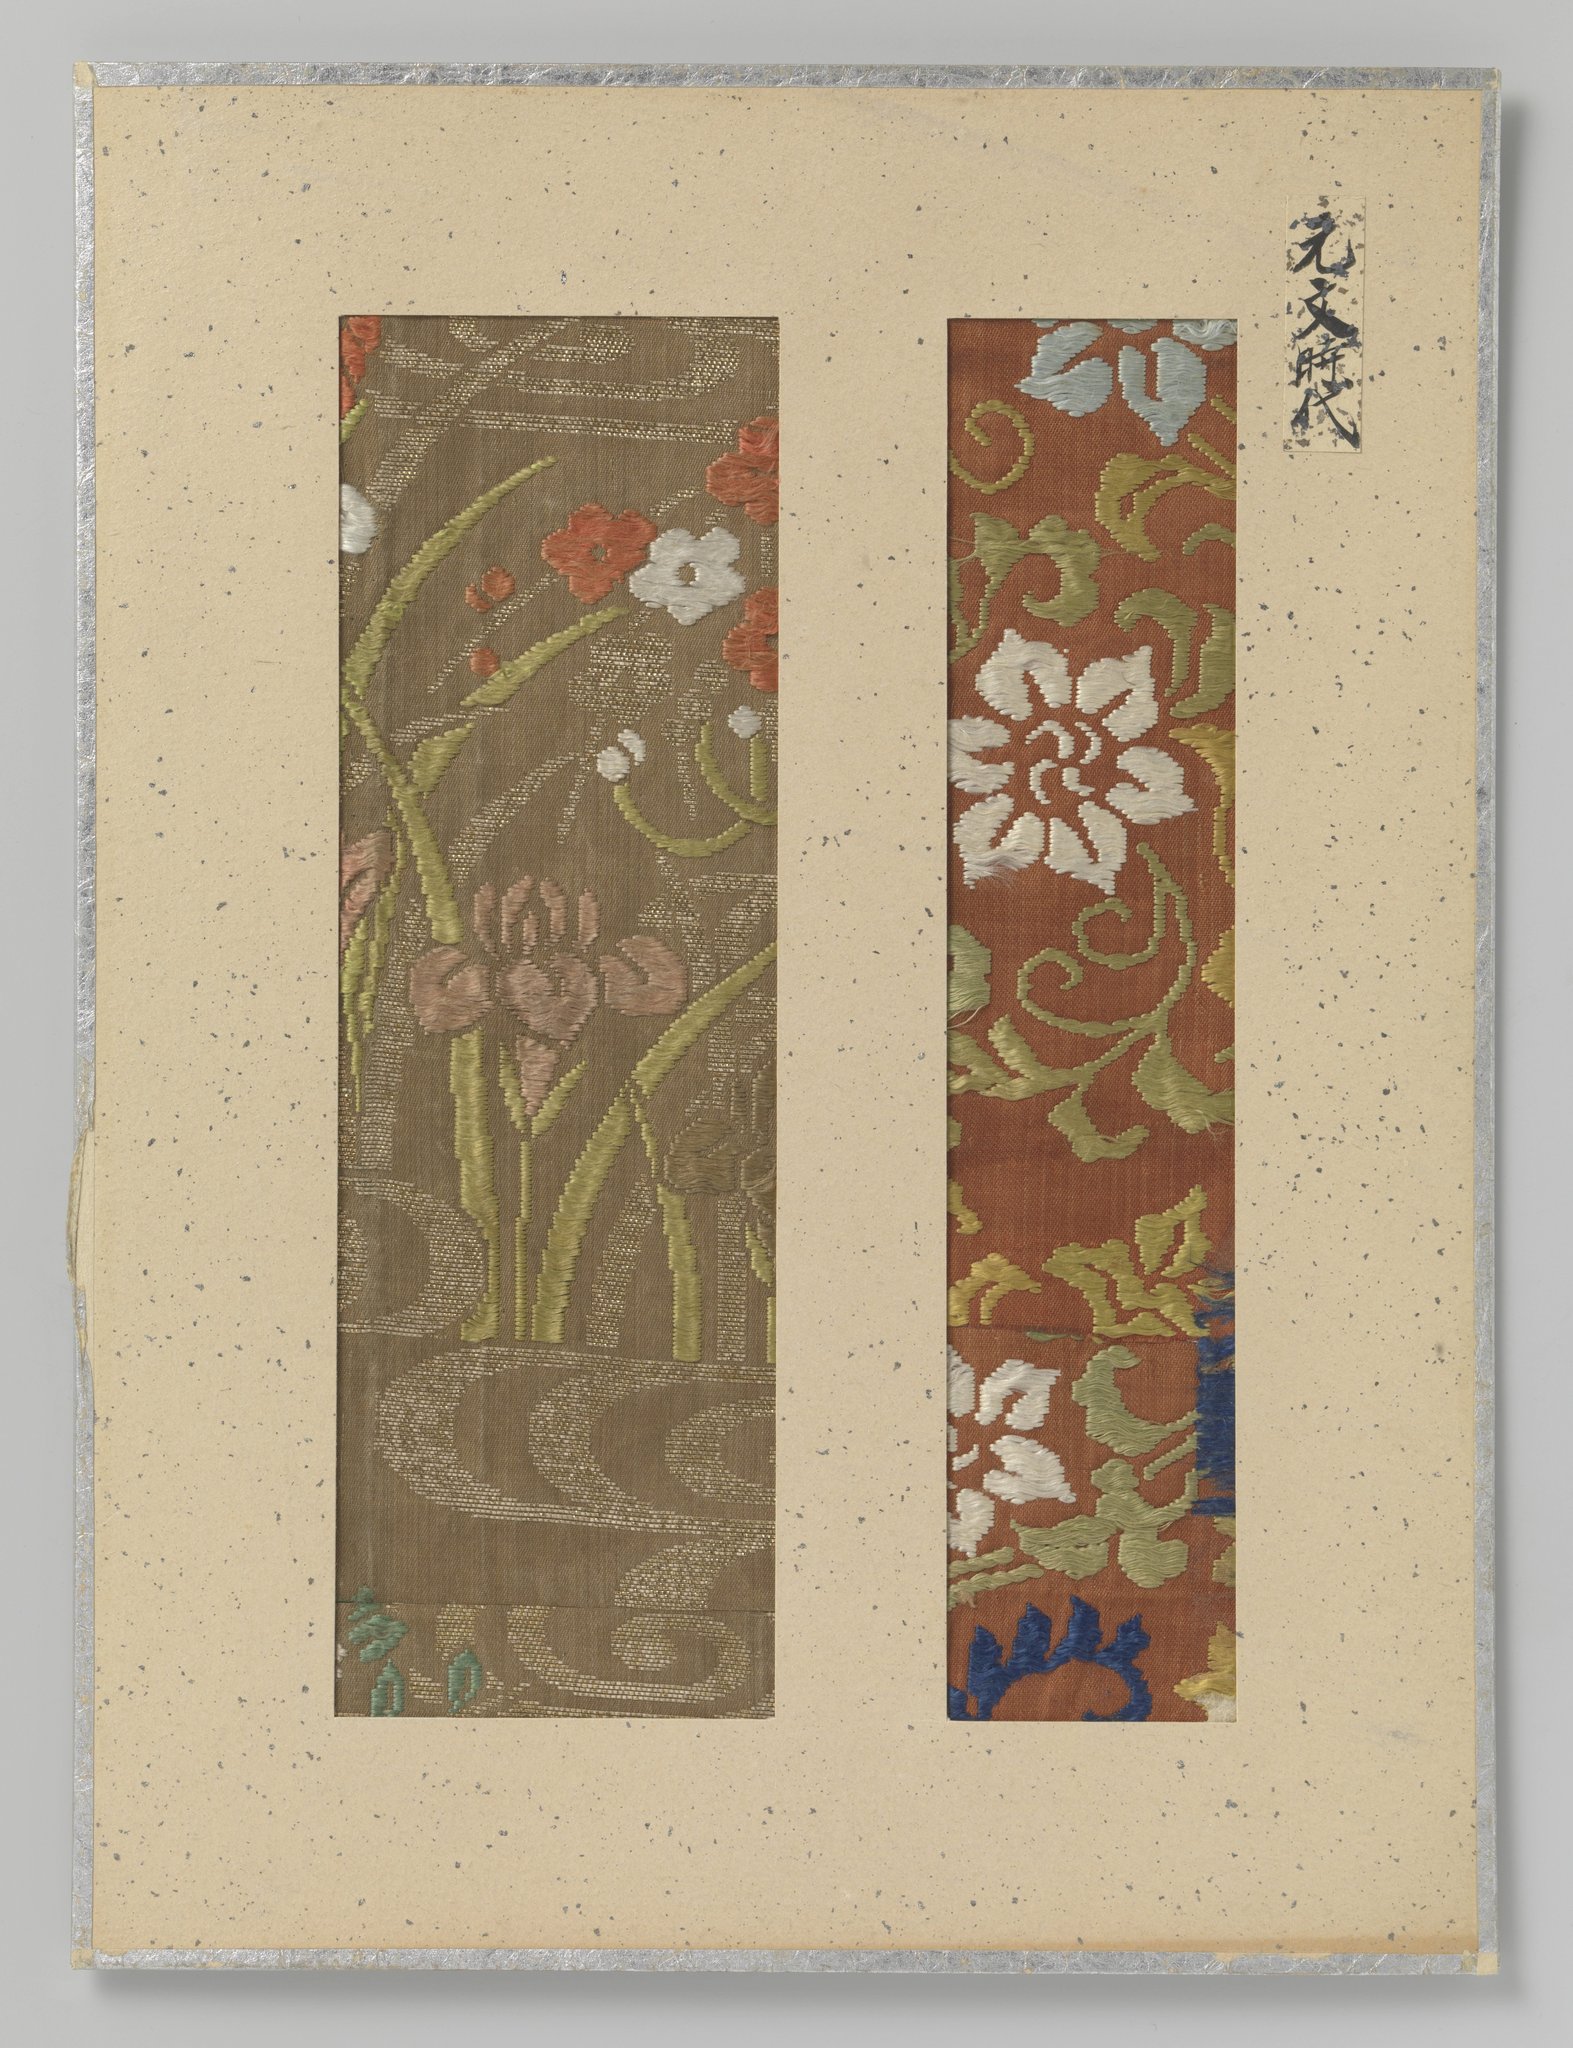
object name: fragment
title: Twee textielfragmenten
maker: Anonymous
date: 1736-1740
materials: gold thread, silk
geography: japan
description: Textielfragmenten, twee, borduursel en kirikane op gouddraad van bloemen en planten.